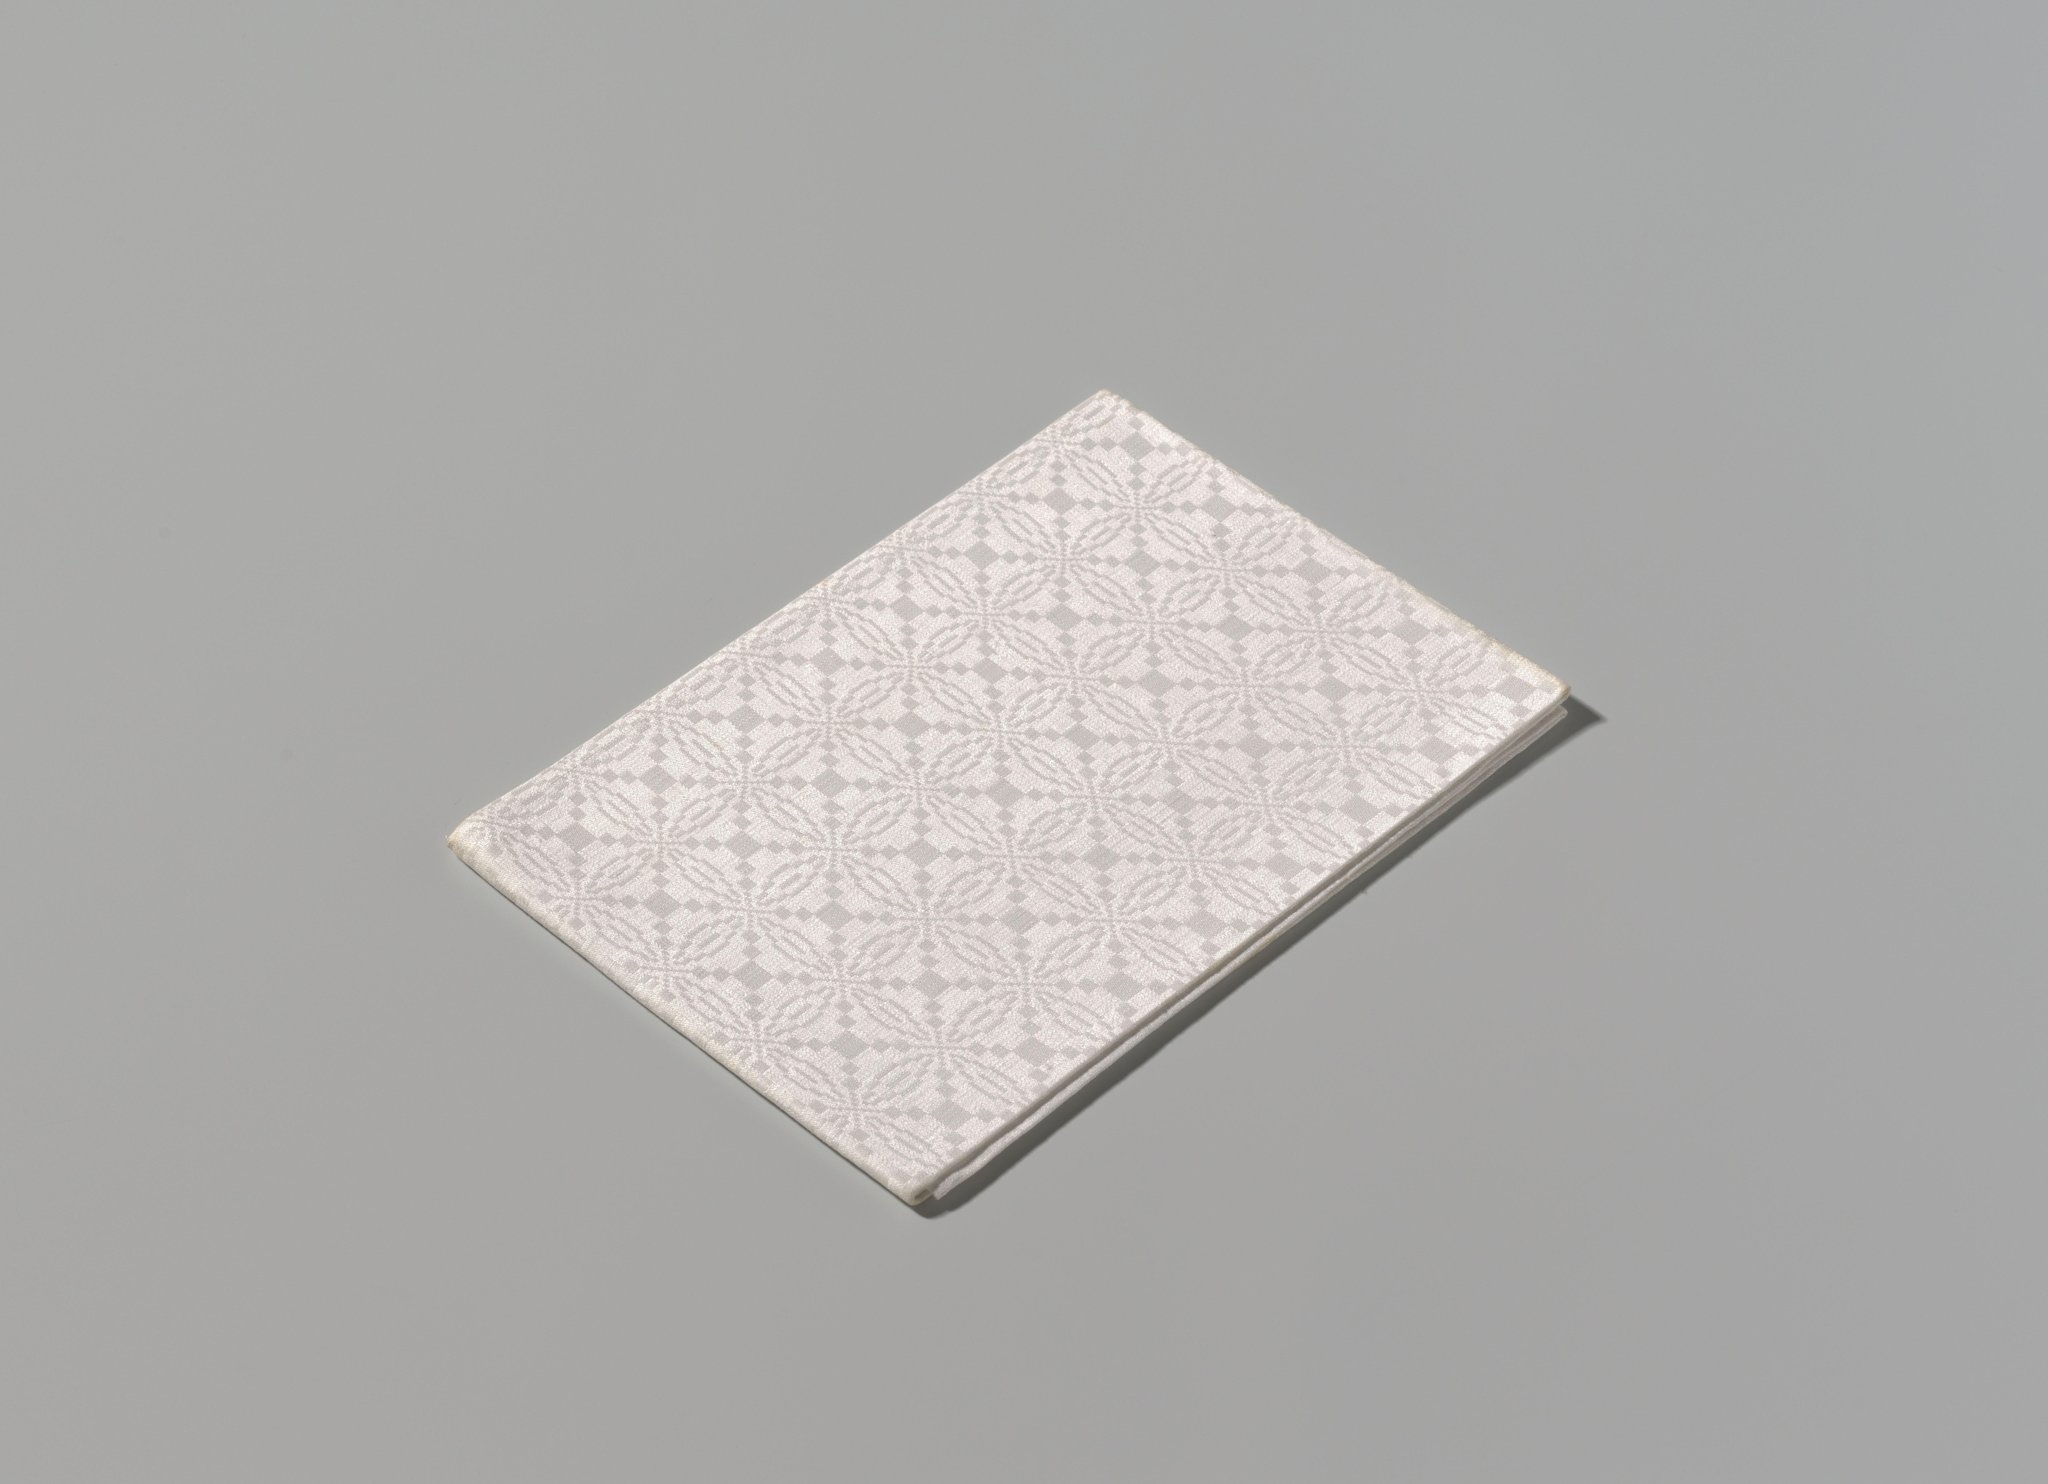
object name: napkin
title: Servet van linnen met pellenpatroon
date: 1620-1660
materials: linen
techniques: peeled fabric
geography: northern netherlands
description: Wit linnen servet met een pellen patroon. Merk AVR HB.